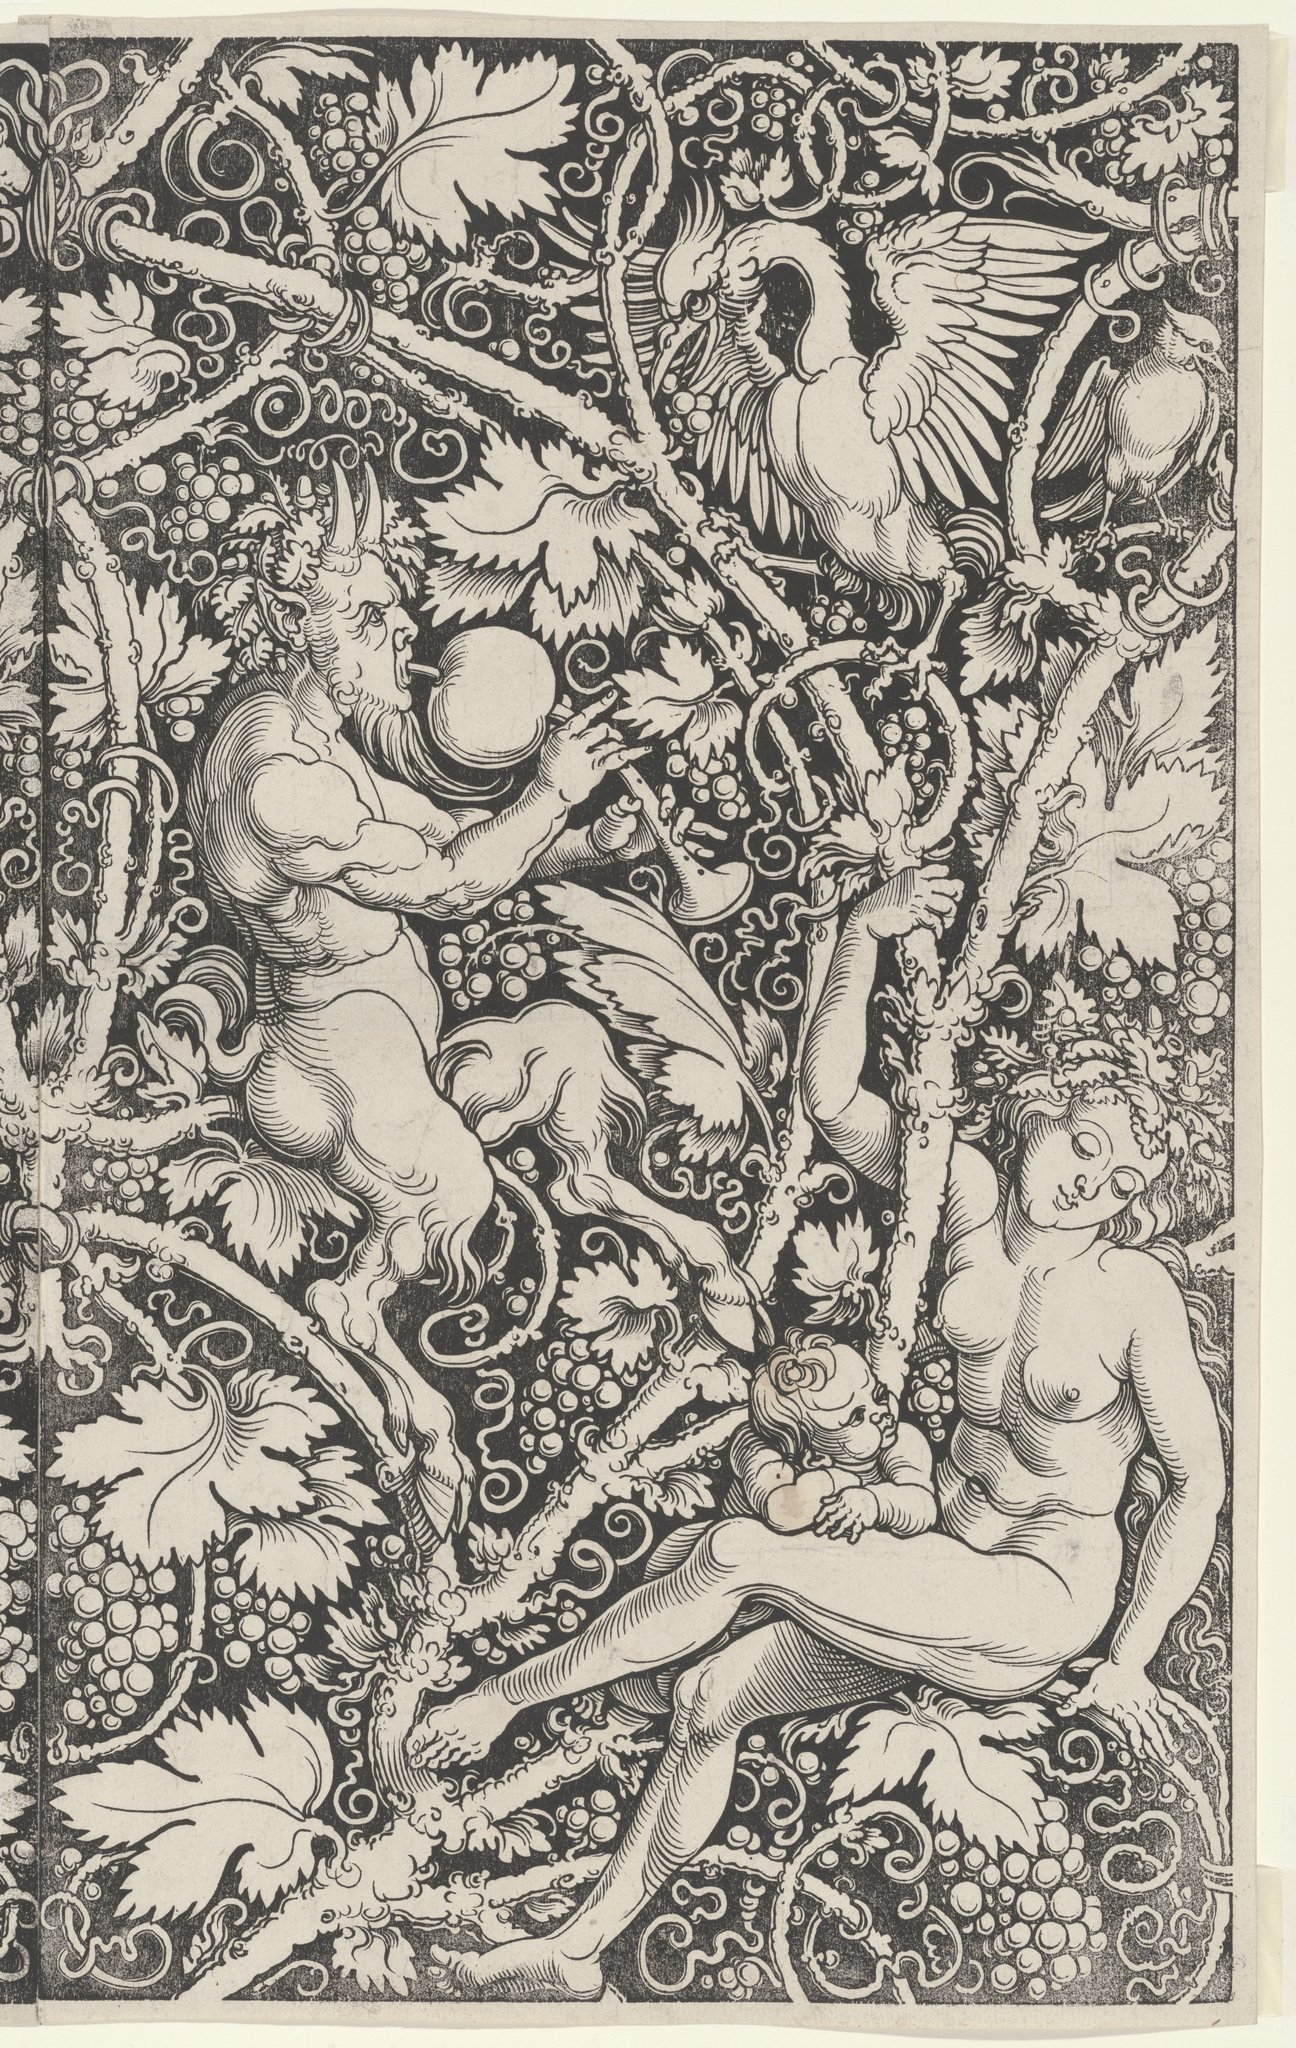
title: Wallpaper with Satyr Family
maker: sebald beham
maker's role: artist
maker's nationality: german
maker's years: 1500-1550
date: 1515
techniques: woodcut